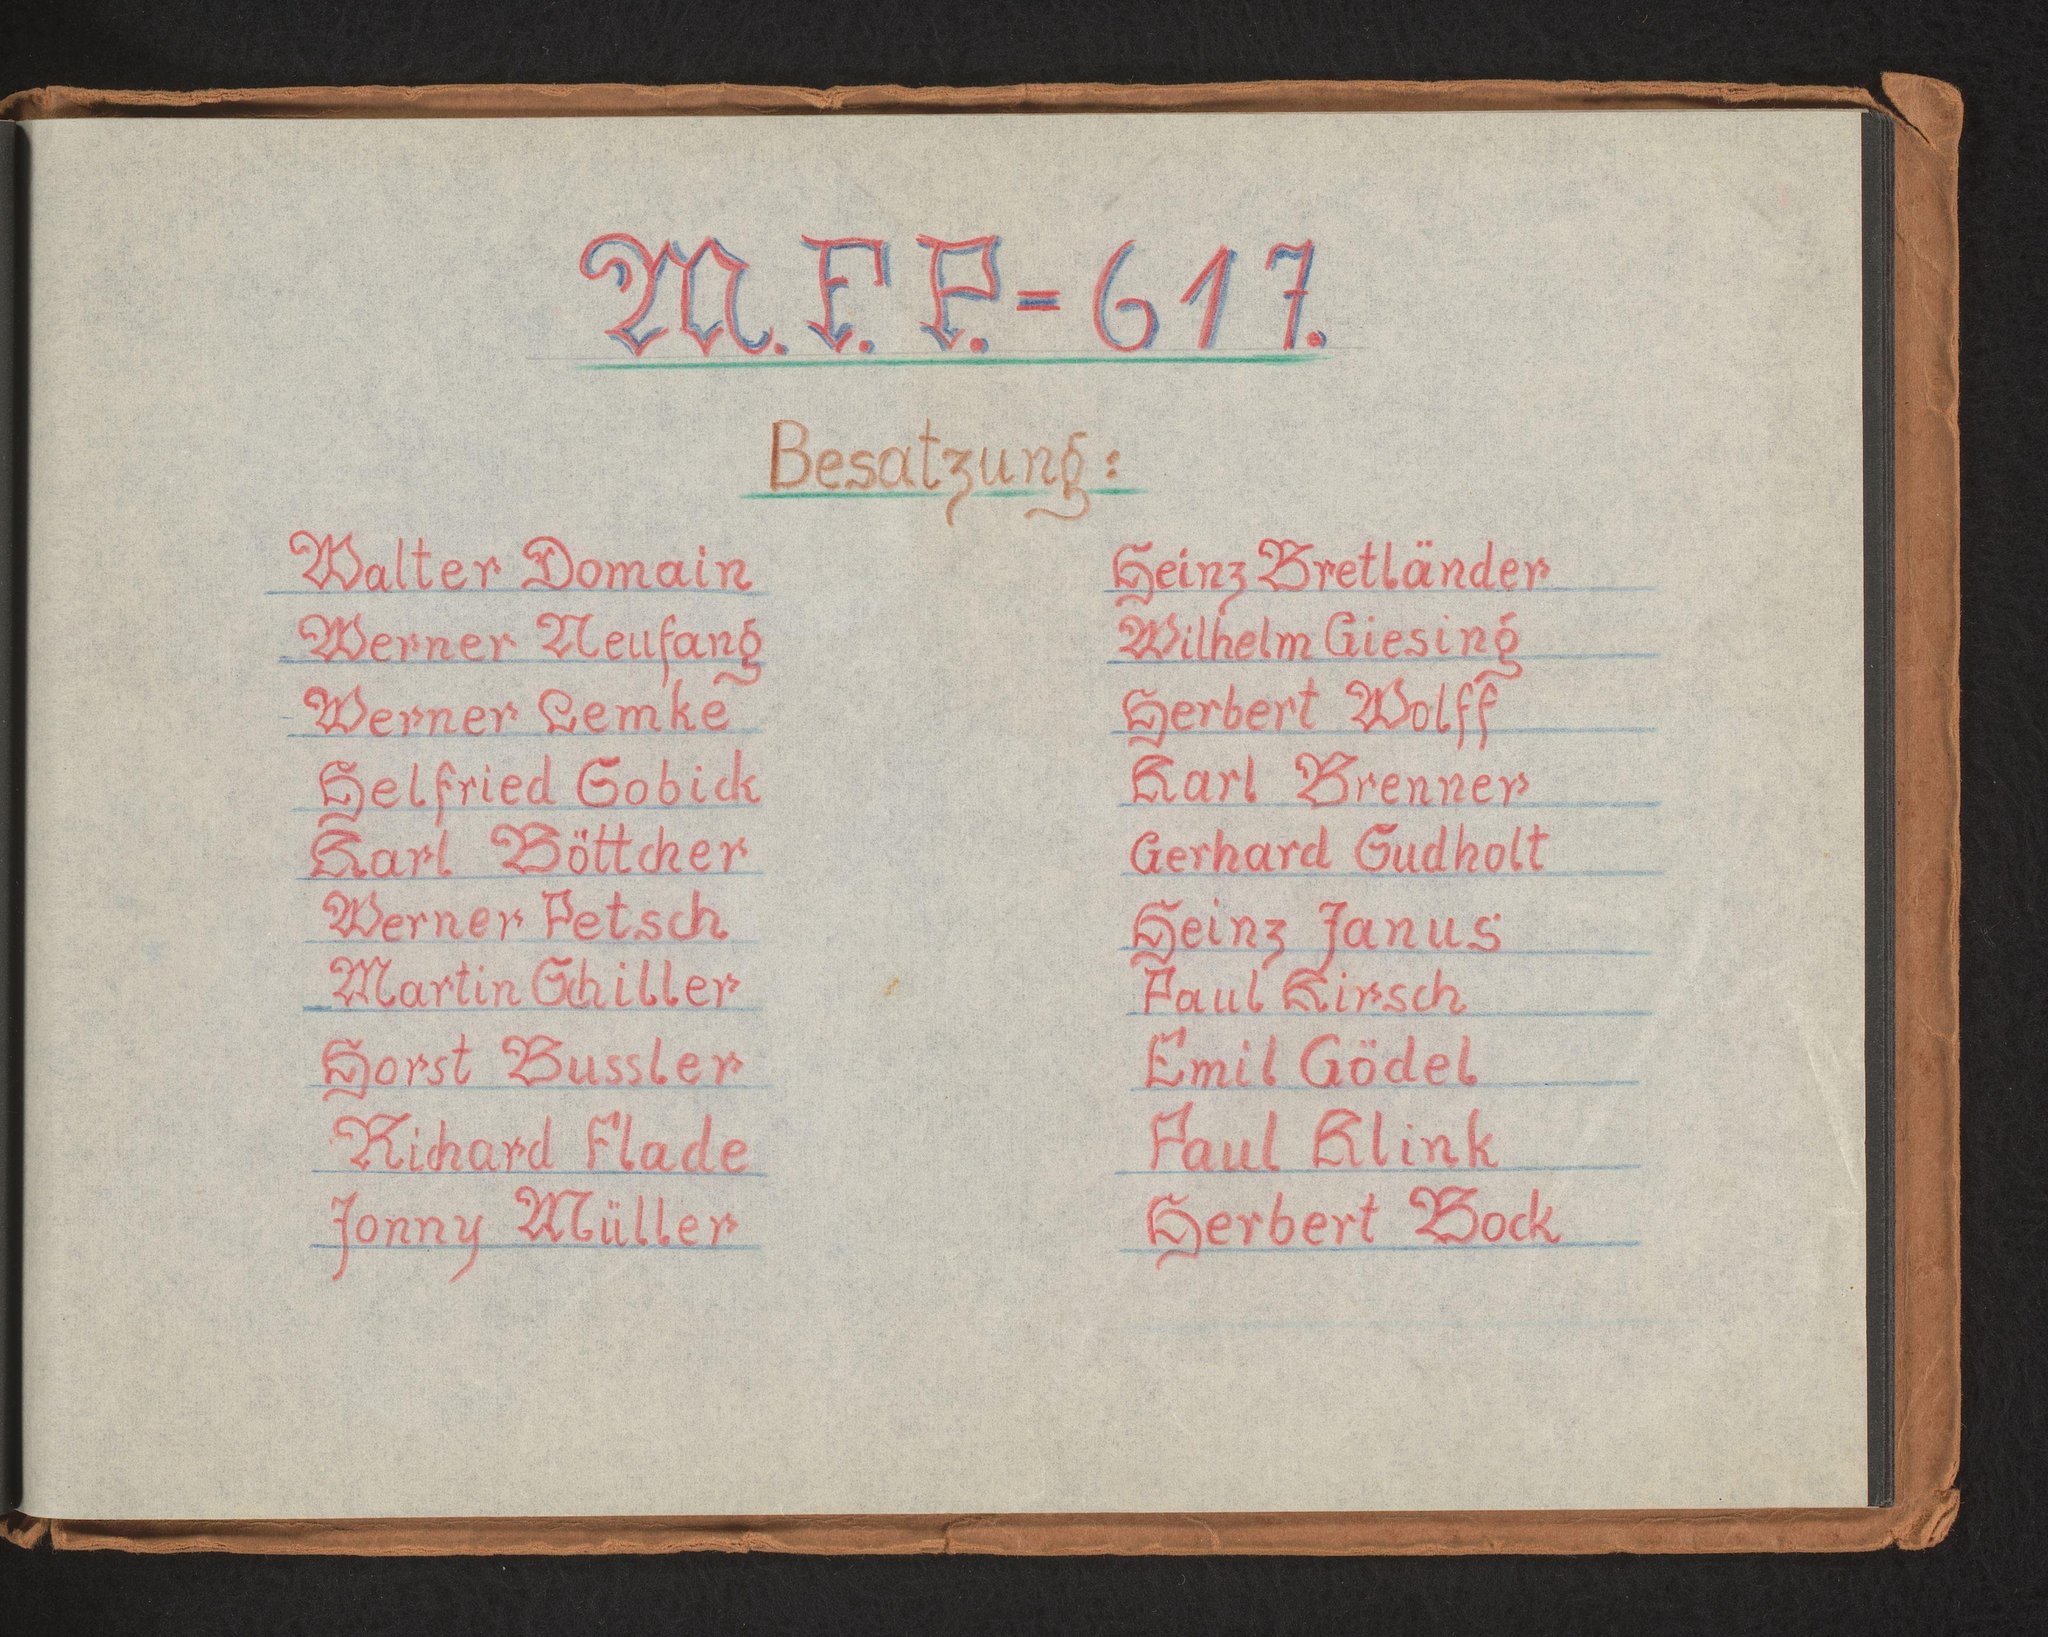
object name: album leaf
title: M.F.P.-617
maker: werner neufang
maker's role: militair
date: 1943-1944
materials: paper, pencil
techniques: writing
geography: germany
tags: werner neufang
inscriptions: inscription: ‘M.F.P.-617 / Besatzung: ...’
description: Blad met een handgeschreven lijst met de namen van de manschappen van de M.F.P.-617, de eenheid waartoe ook Werner behoorde. Tussenblad tussen bladzijde 24 en 25. Onderdeel van een fotoalbum over de Duitse Werner Neufang van de Kriegsmarine en de Nederlandse Thea Driesen.